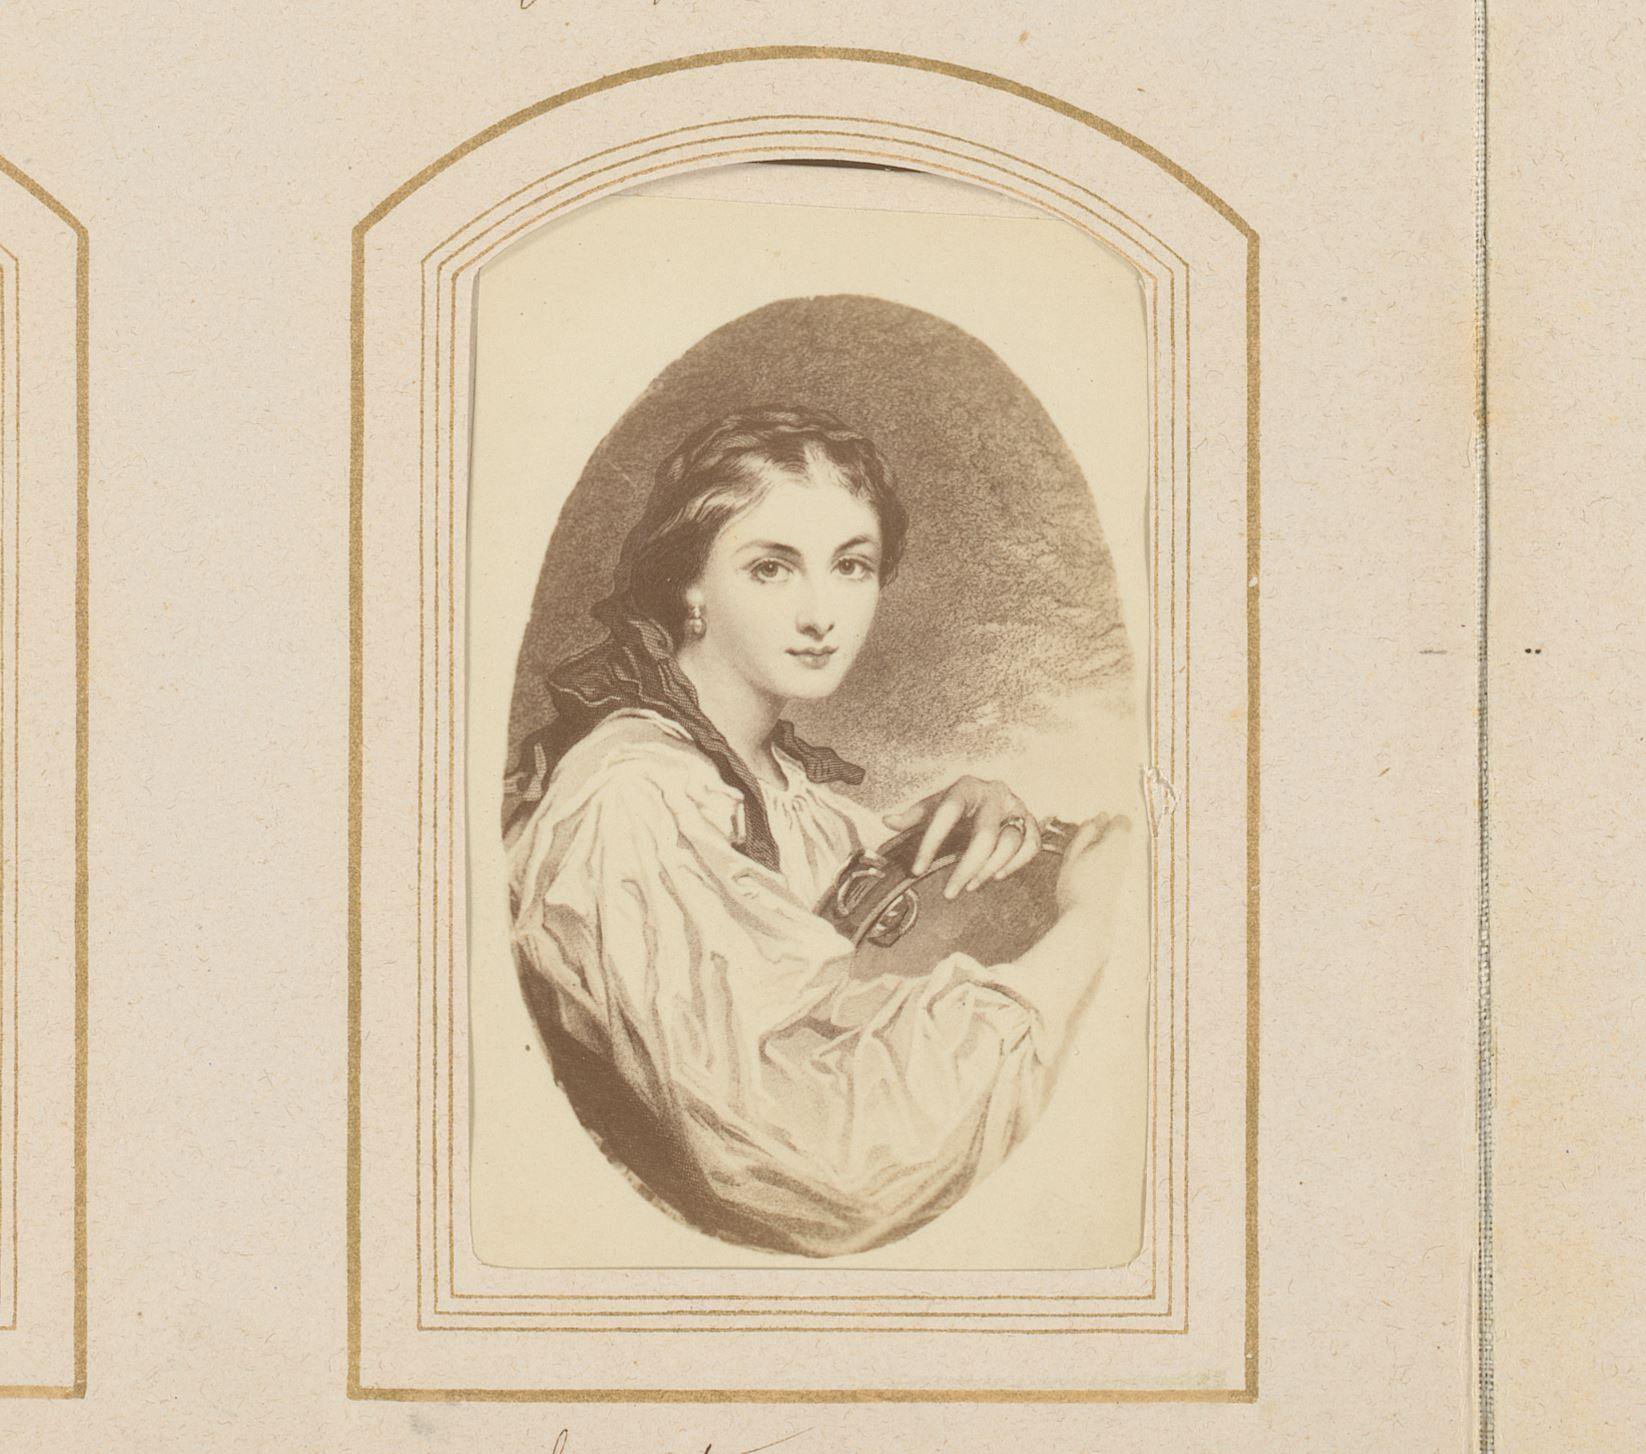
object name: carte de visite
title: Fotoreproductie van La Sorrentina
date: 1870-1890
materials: cardboard, photographic support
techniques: albumen print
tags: adult woman, painting, drawing and the graphic arts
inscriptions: annotation: ‘die [...]’, inscription: ‘Buckner./ 1794./ La Sorrentina.’